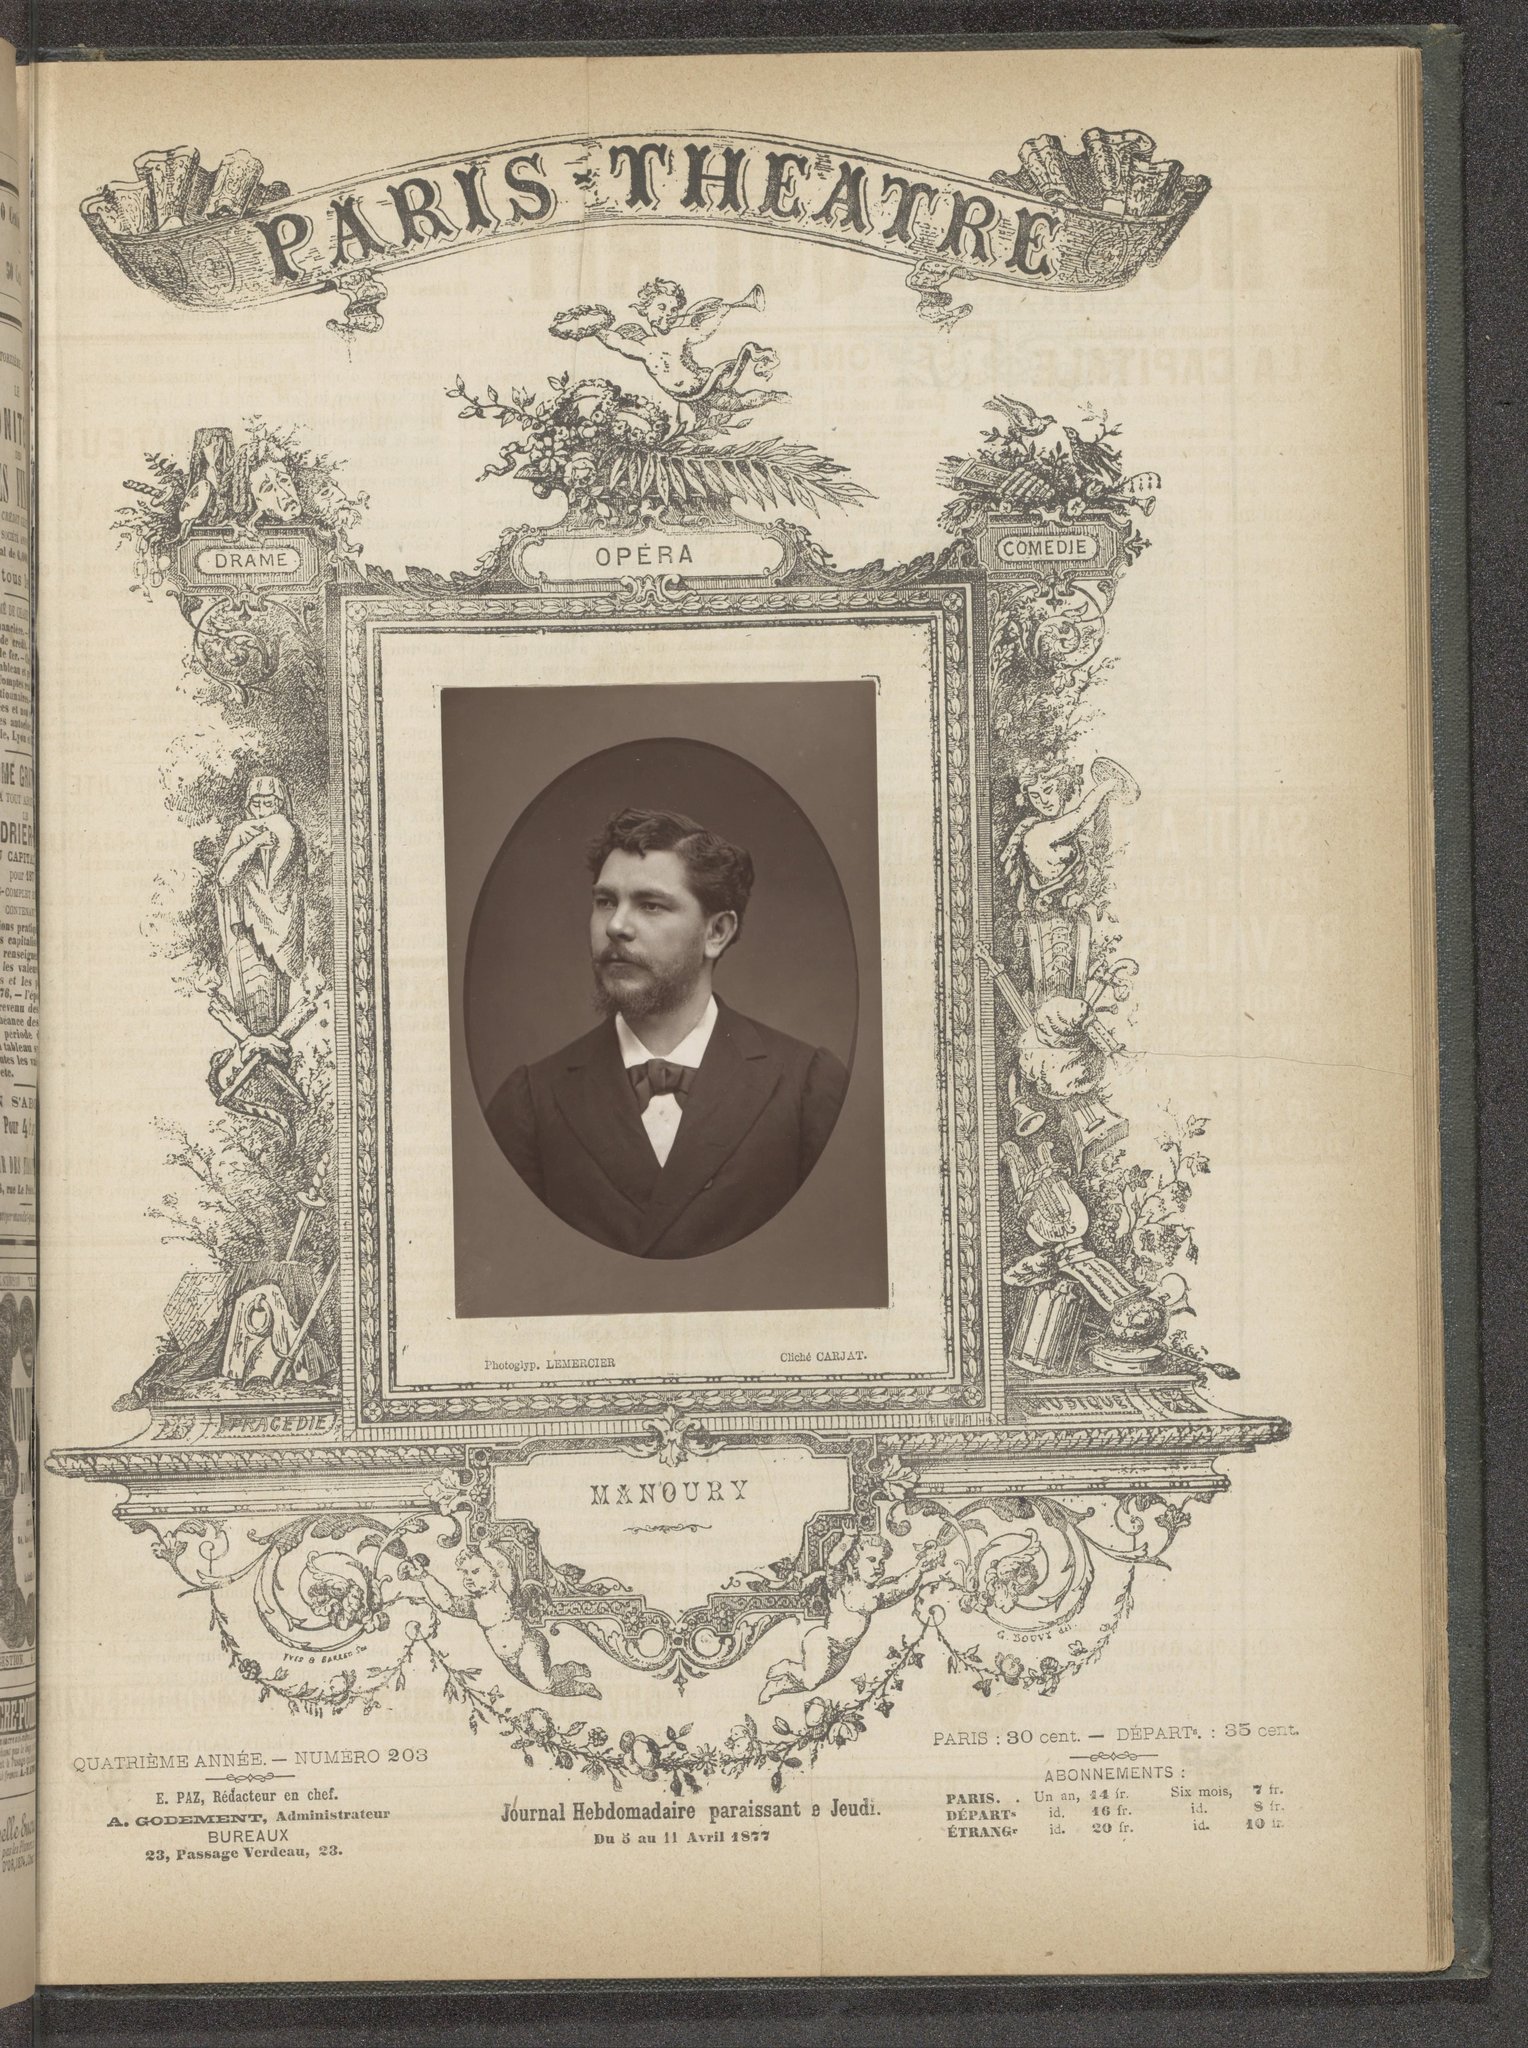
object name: photomechanical print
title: Portret van Théophile-Adolphe Manoury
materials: paper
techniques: woodburytype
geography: france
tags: portrait of opera-singer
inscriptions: inscription: ‘Journal Hebdomadaire paraissant le Jeudi, Du 5 ai 11 Avril 1877’, number: ‘Numéro 203’